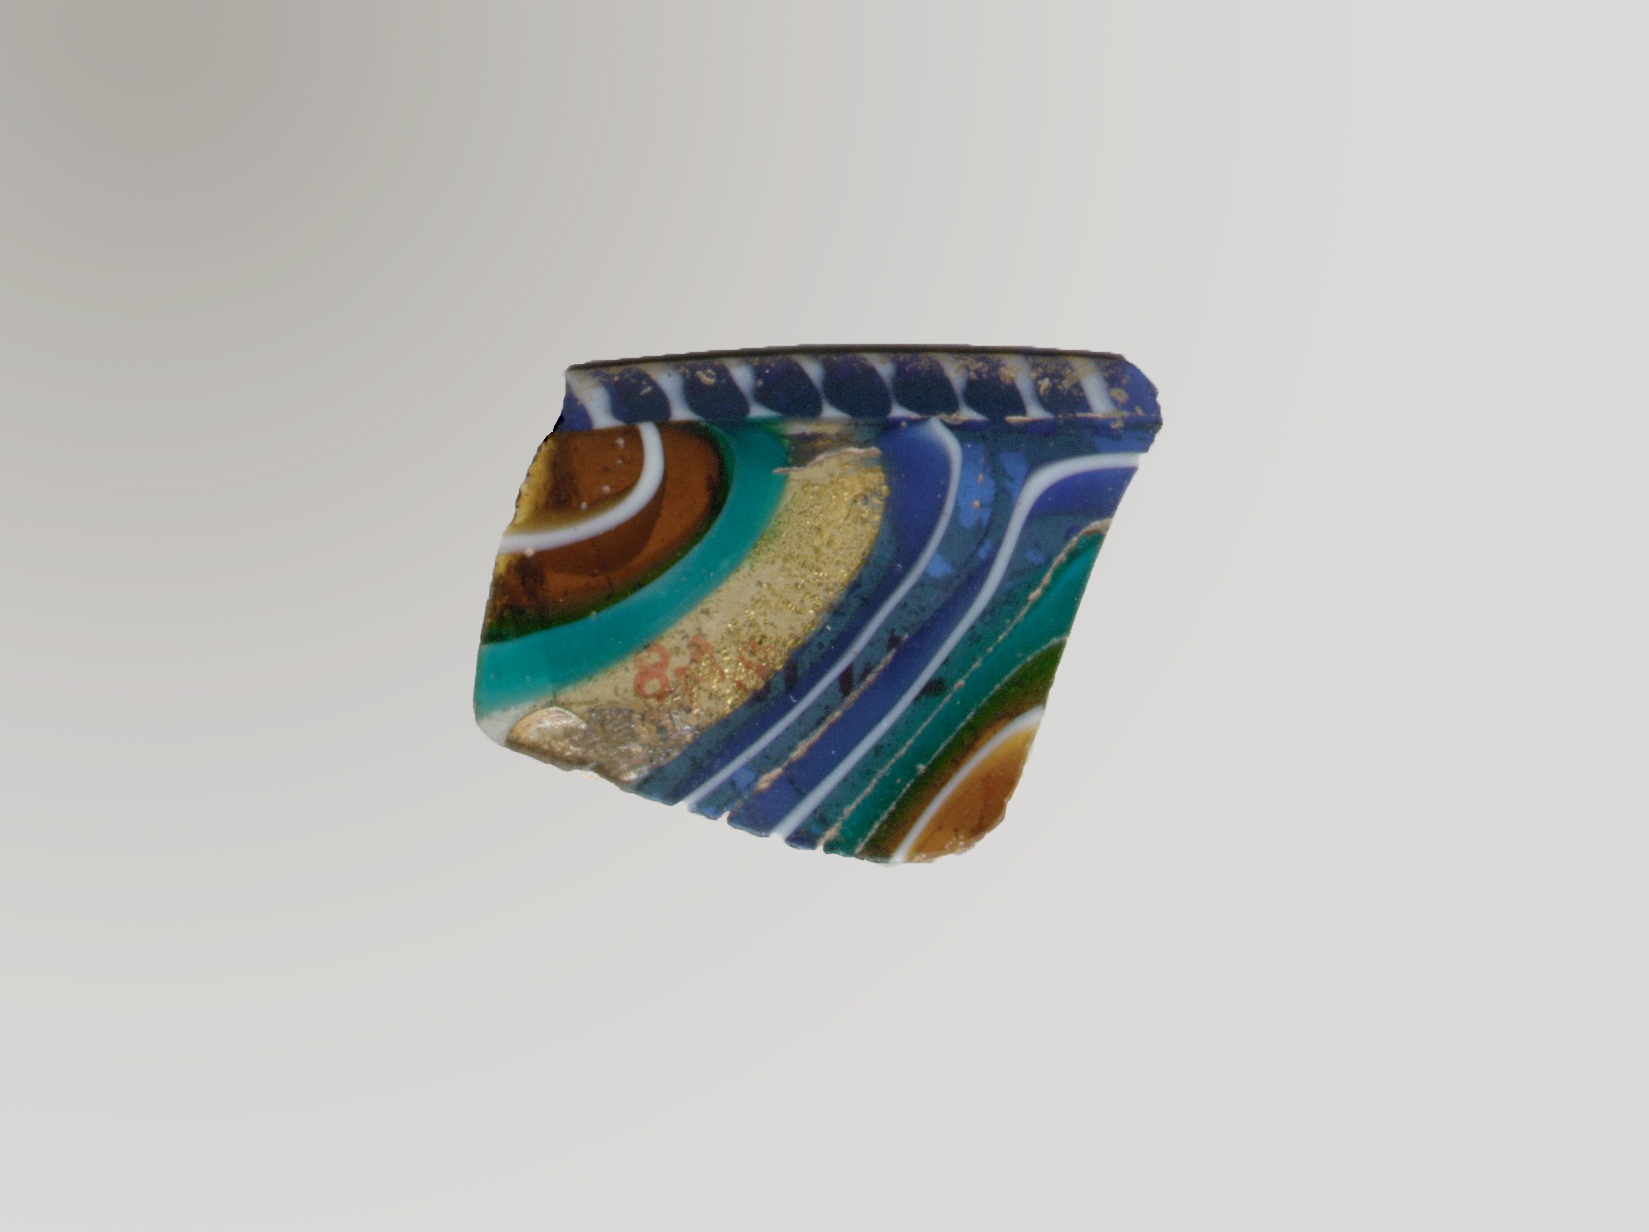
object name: fragment, gold band mosaic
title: Glass gold-band mosaic bowl fragment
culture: roman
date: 34 BCE-33 CE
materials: glass